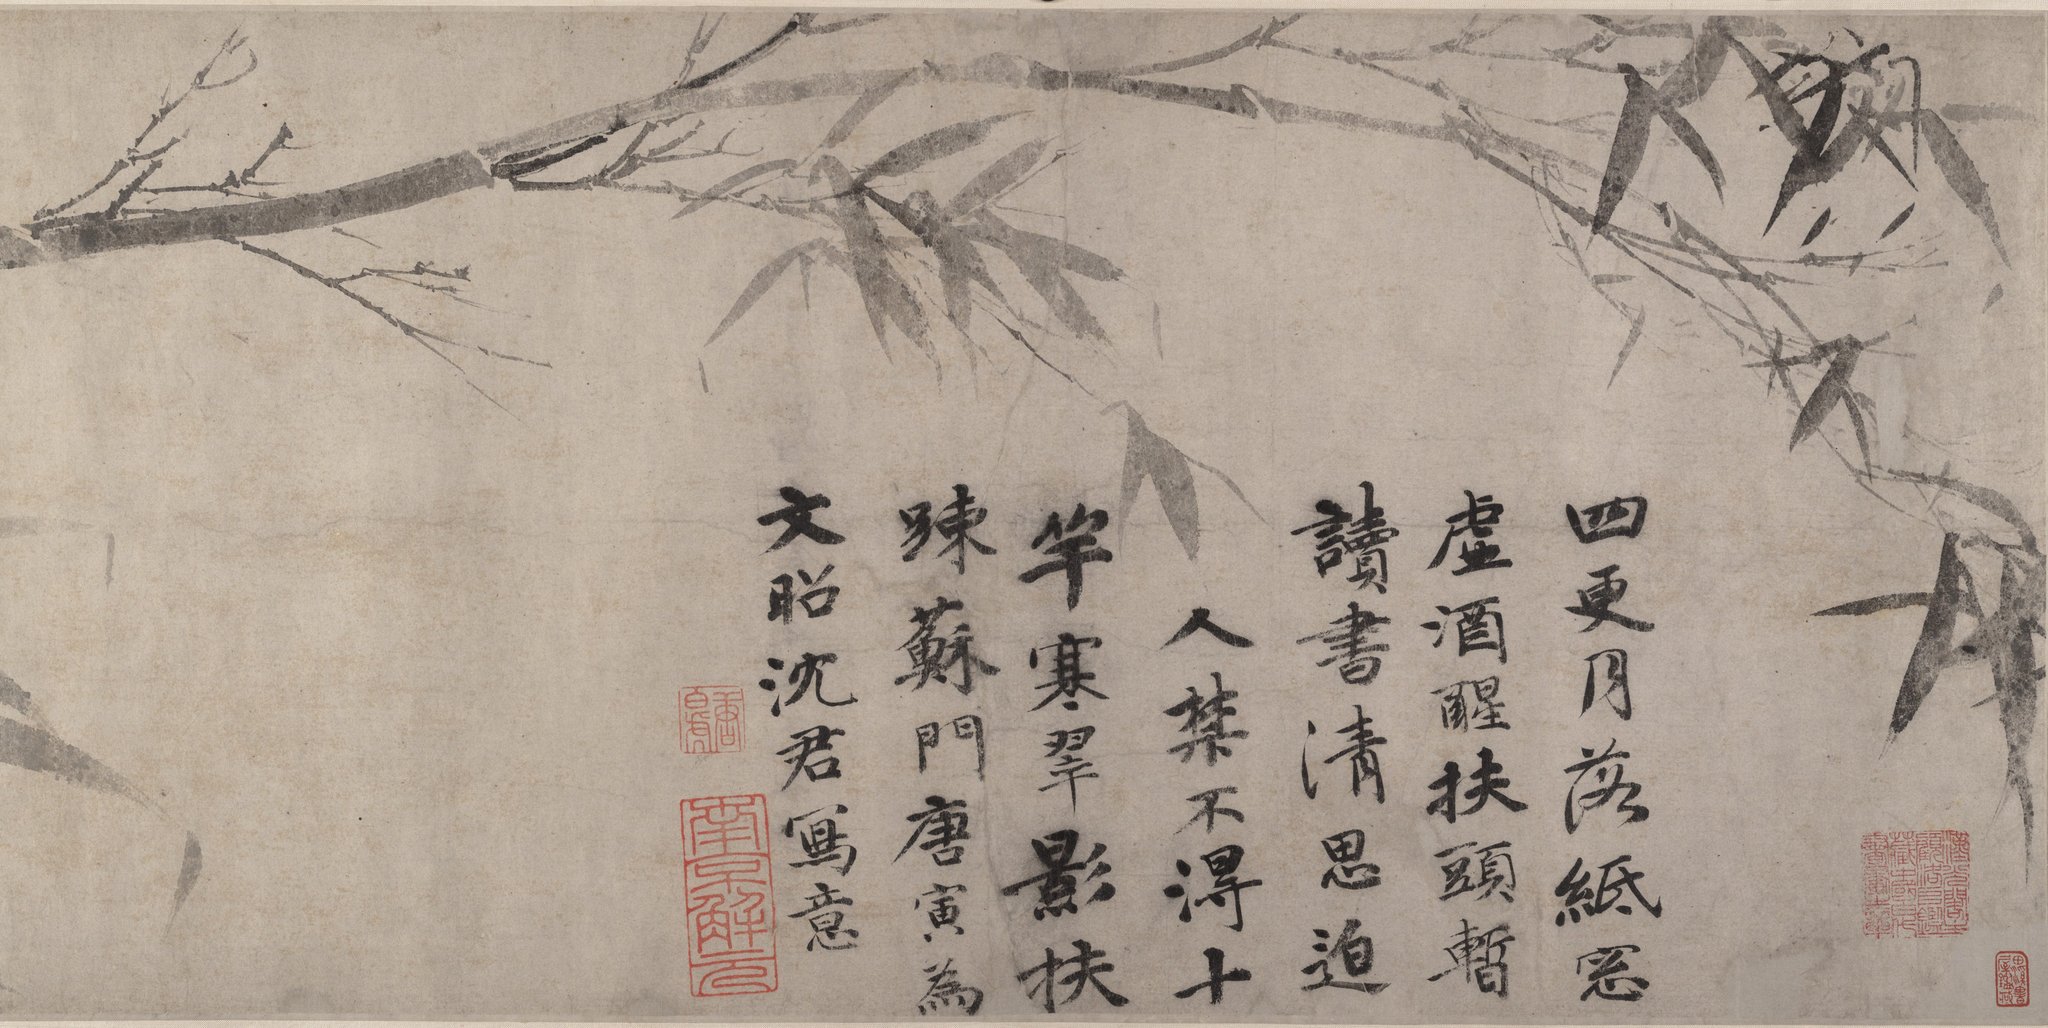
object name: handscroll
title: Ink bamboo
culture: chinese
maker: tang yin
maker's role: artist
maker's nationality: chinese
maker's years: 1470-1524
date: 1501-1533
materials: ink, paper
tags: bamboo